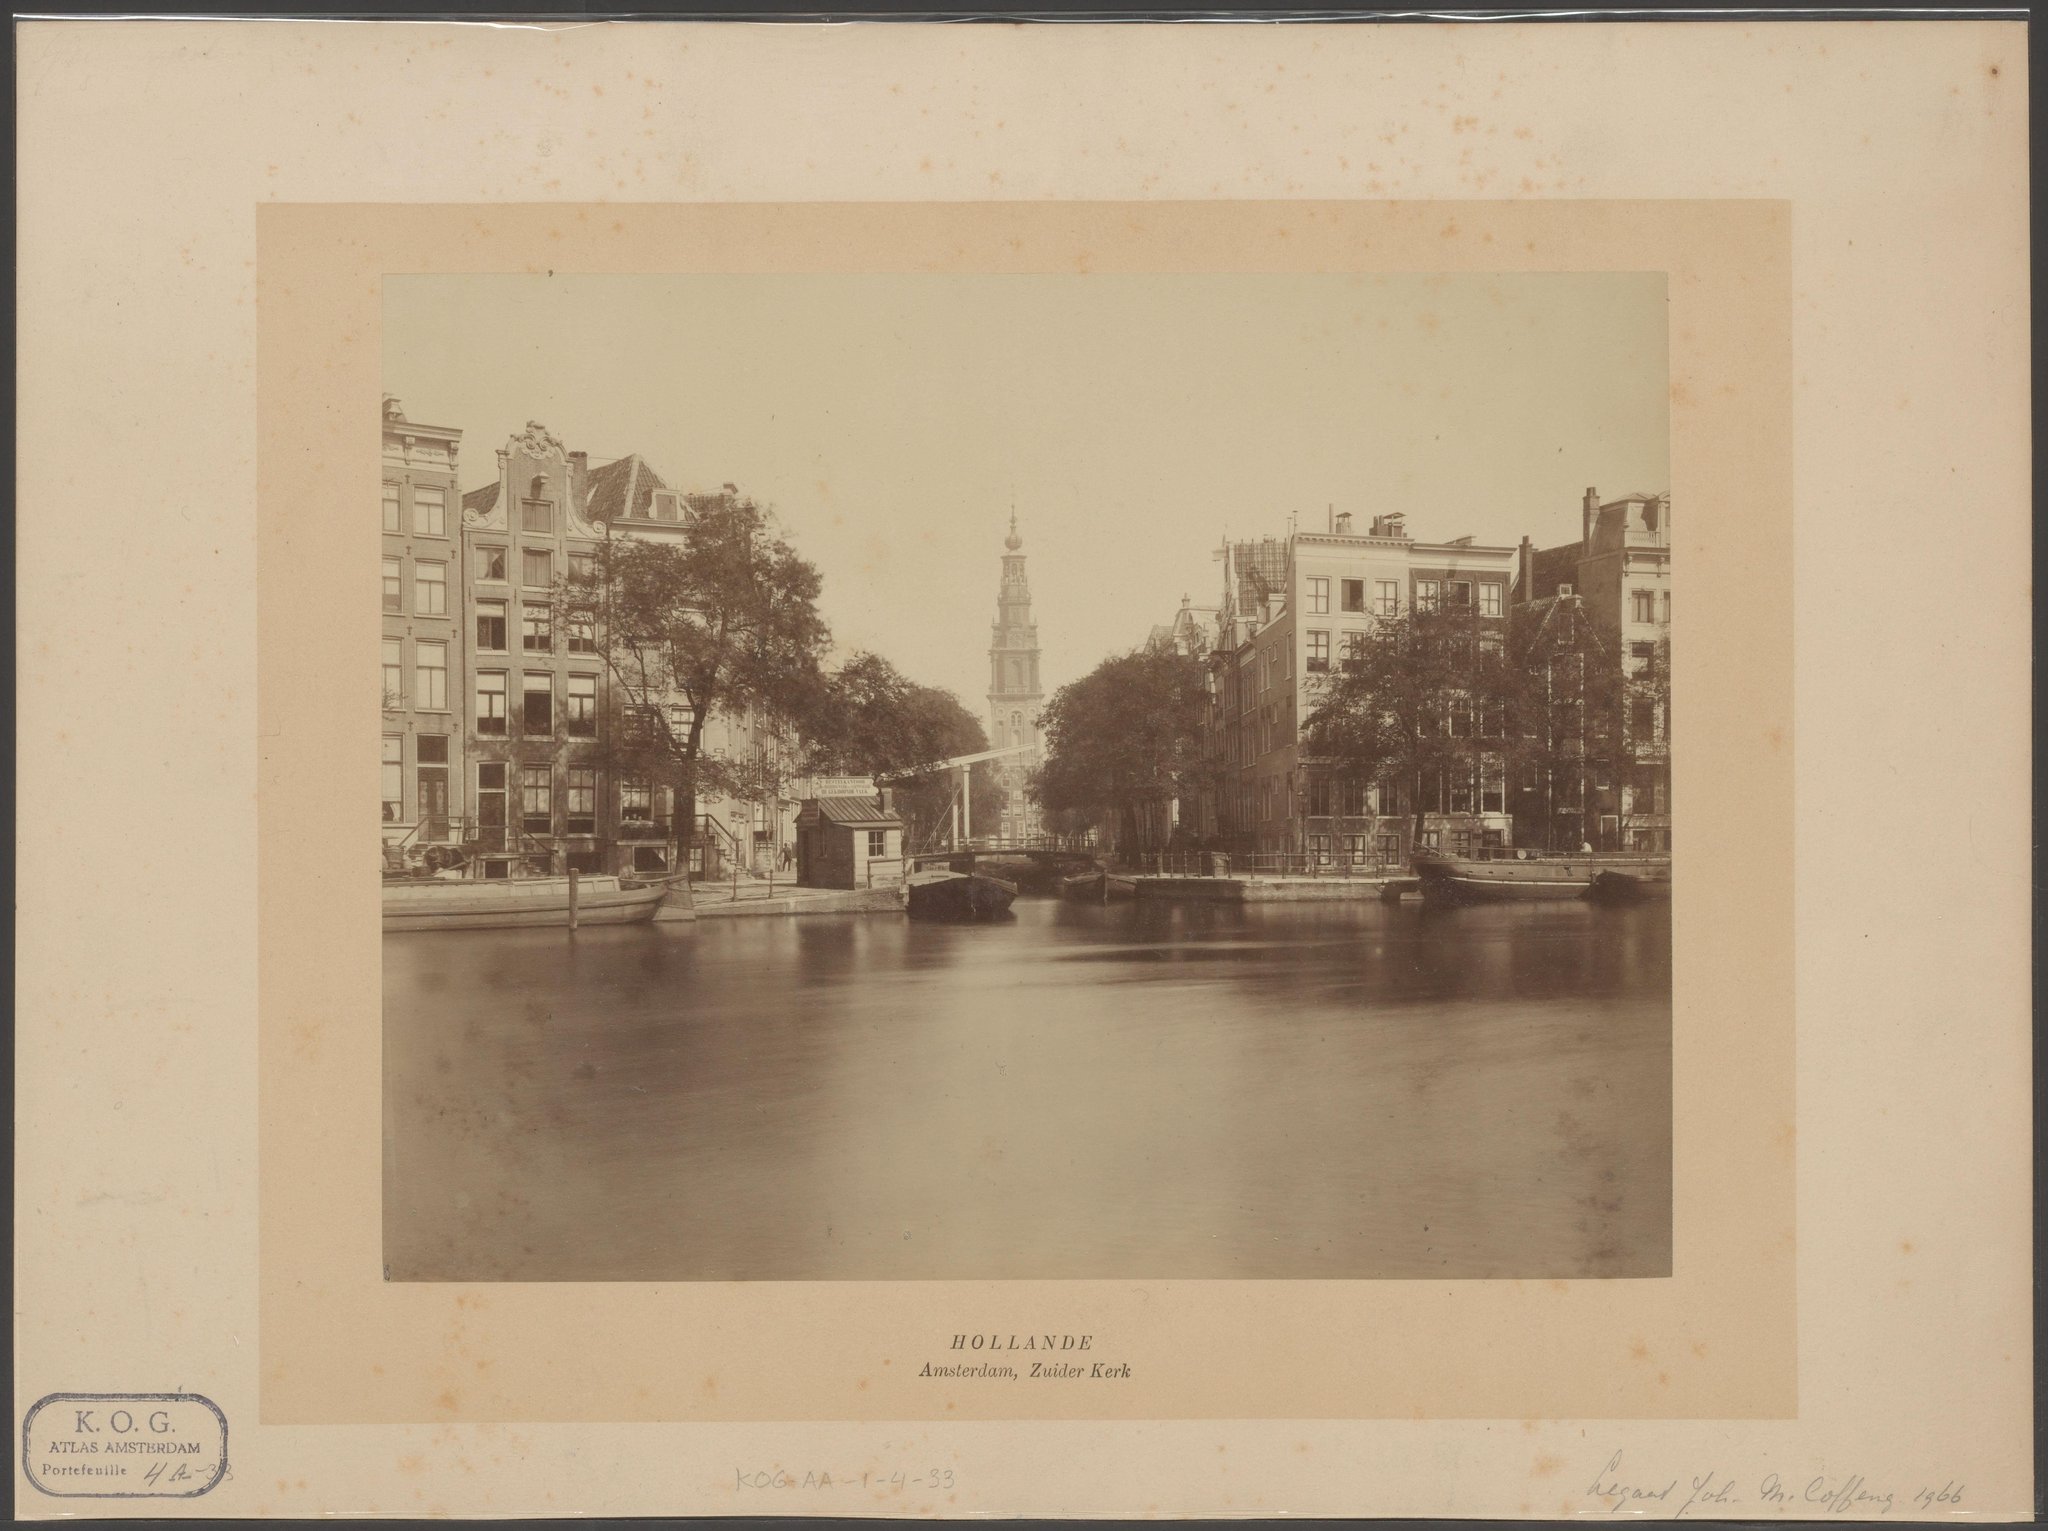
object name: photograph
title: Gezicht op de Groenburgwal en de Zuiderkerkstoren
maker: Anonymous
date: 1850-1915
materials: cardboard, paper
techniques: albumen print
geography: amsterdam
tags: tower, clock tower ~ monumental adornment, city-view in general; 'veduta', canal, bridge in city across river, canal, etc.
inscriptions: collector's mark: ‘4A-33’ Lugt 1641b, inscription: ‘Legaat Joh. M. Coffeng. 1966’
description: Onderwerpsrubriek binnen de Atlas Amsterdam: Amstel van Doelensluis tot Blauwbrug.